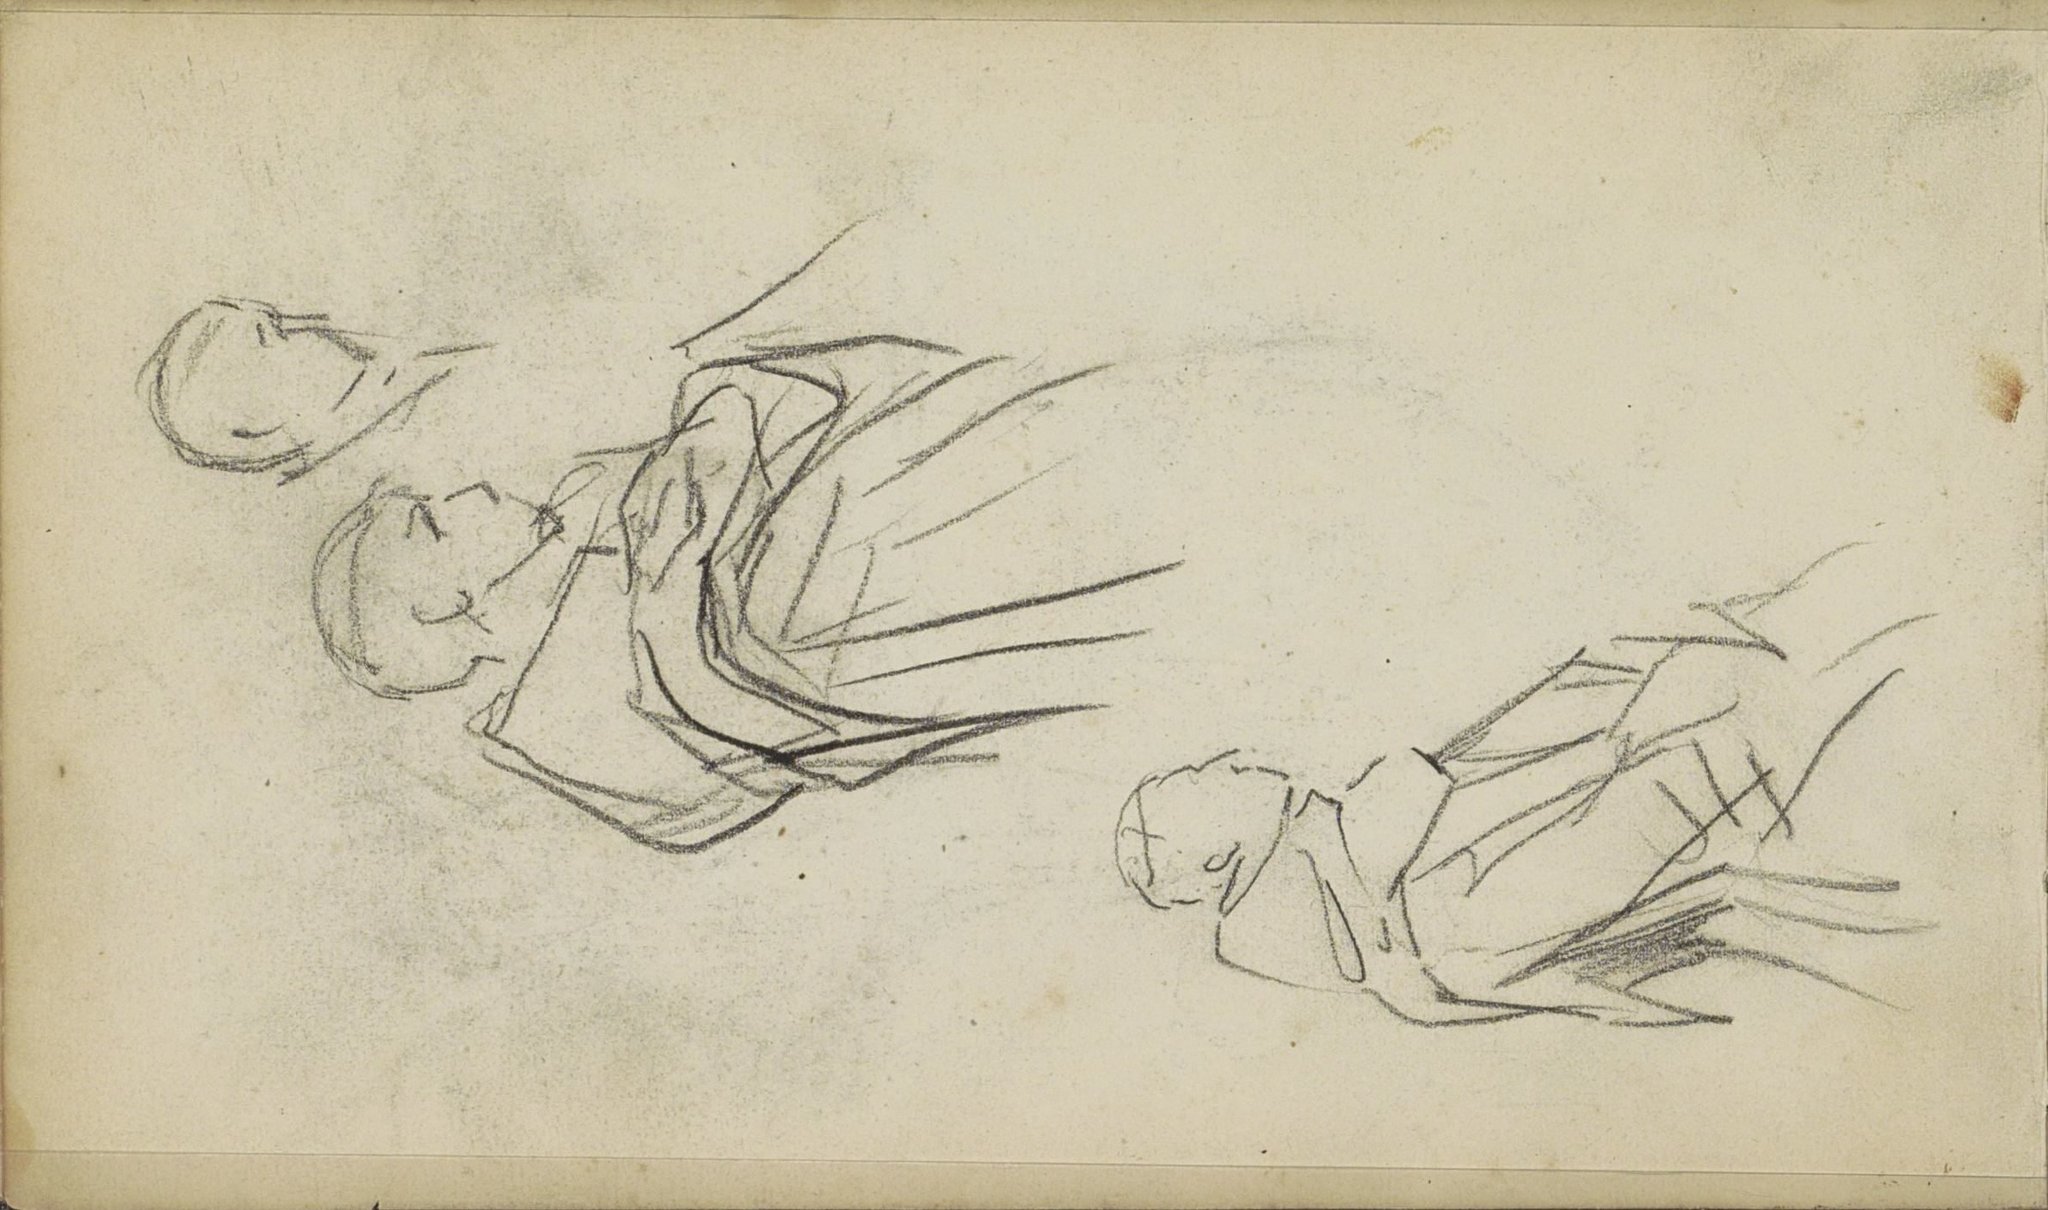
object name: sketchbook leaf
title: Monniken in pij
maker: johannes bosboom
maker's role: draughtsman, painter, print maker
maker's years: 1817-1891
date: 1845-1891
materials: chalk, paper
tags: monk(s), friar(s)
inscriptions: annotation: ‘Tor G eer prijs en taem/ Zoo hu[...] krijgt den Mol/ Zijn naem’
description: Blad 14 verso uit een schetsboek met 46 bladen.